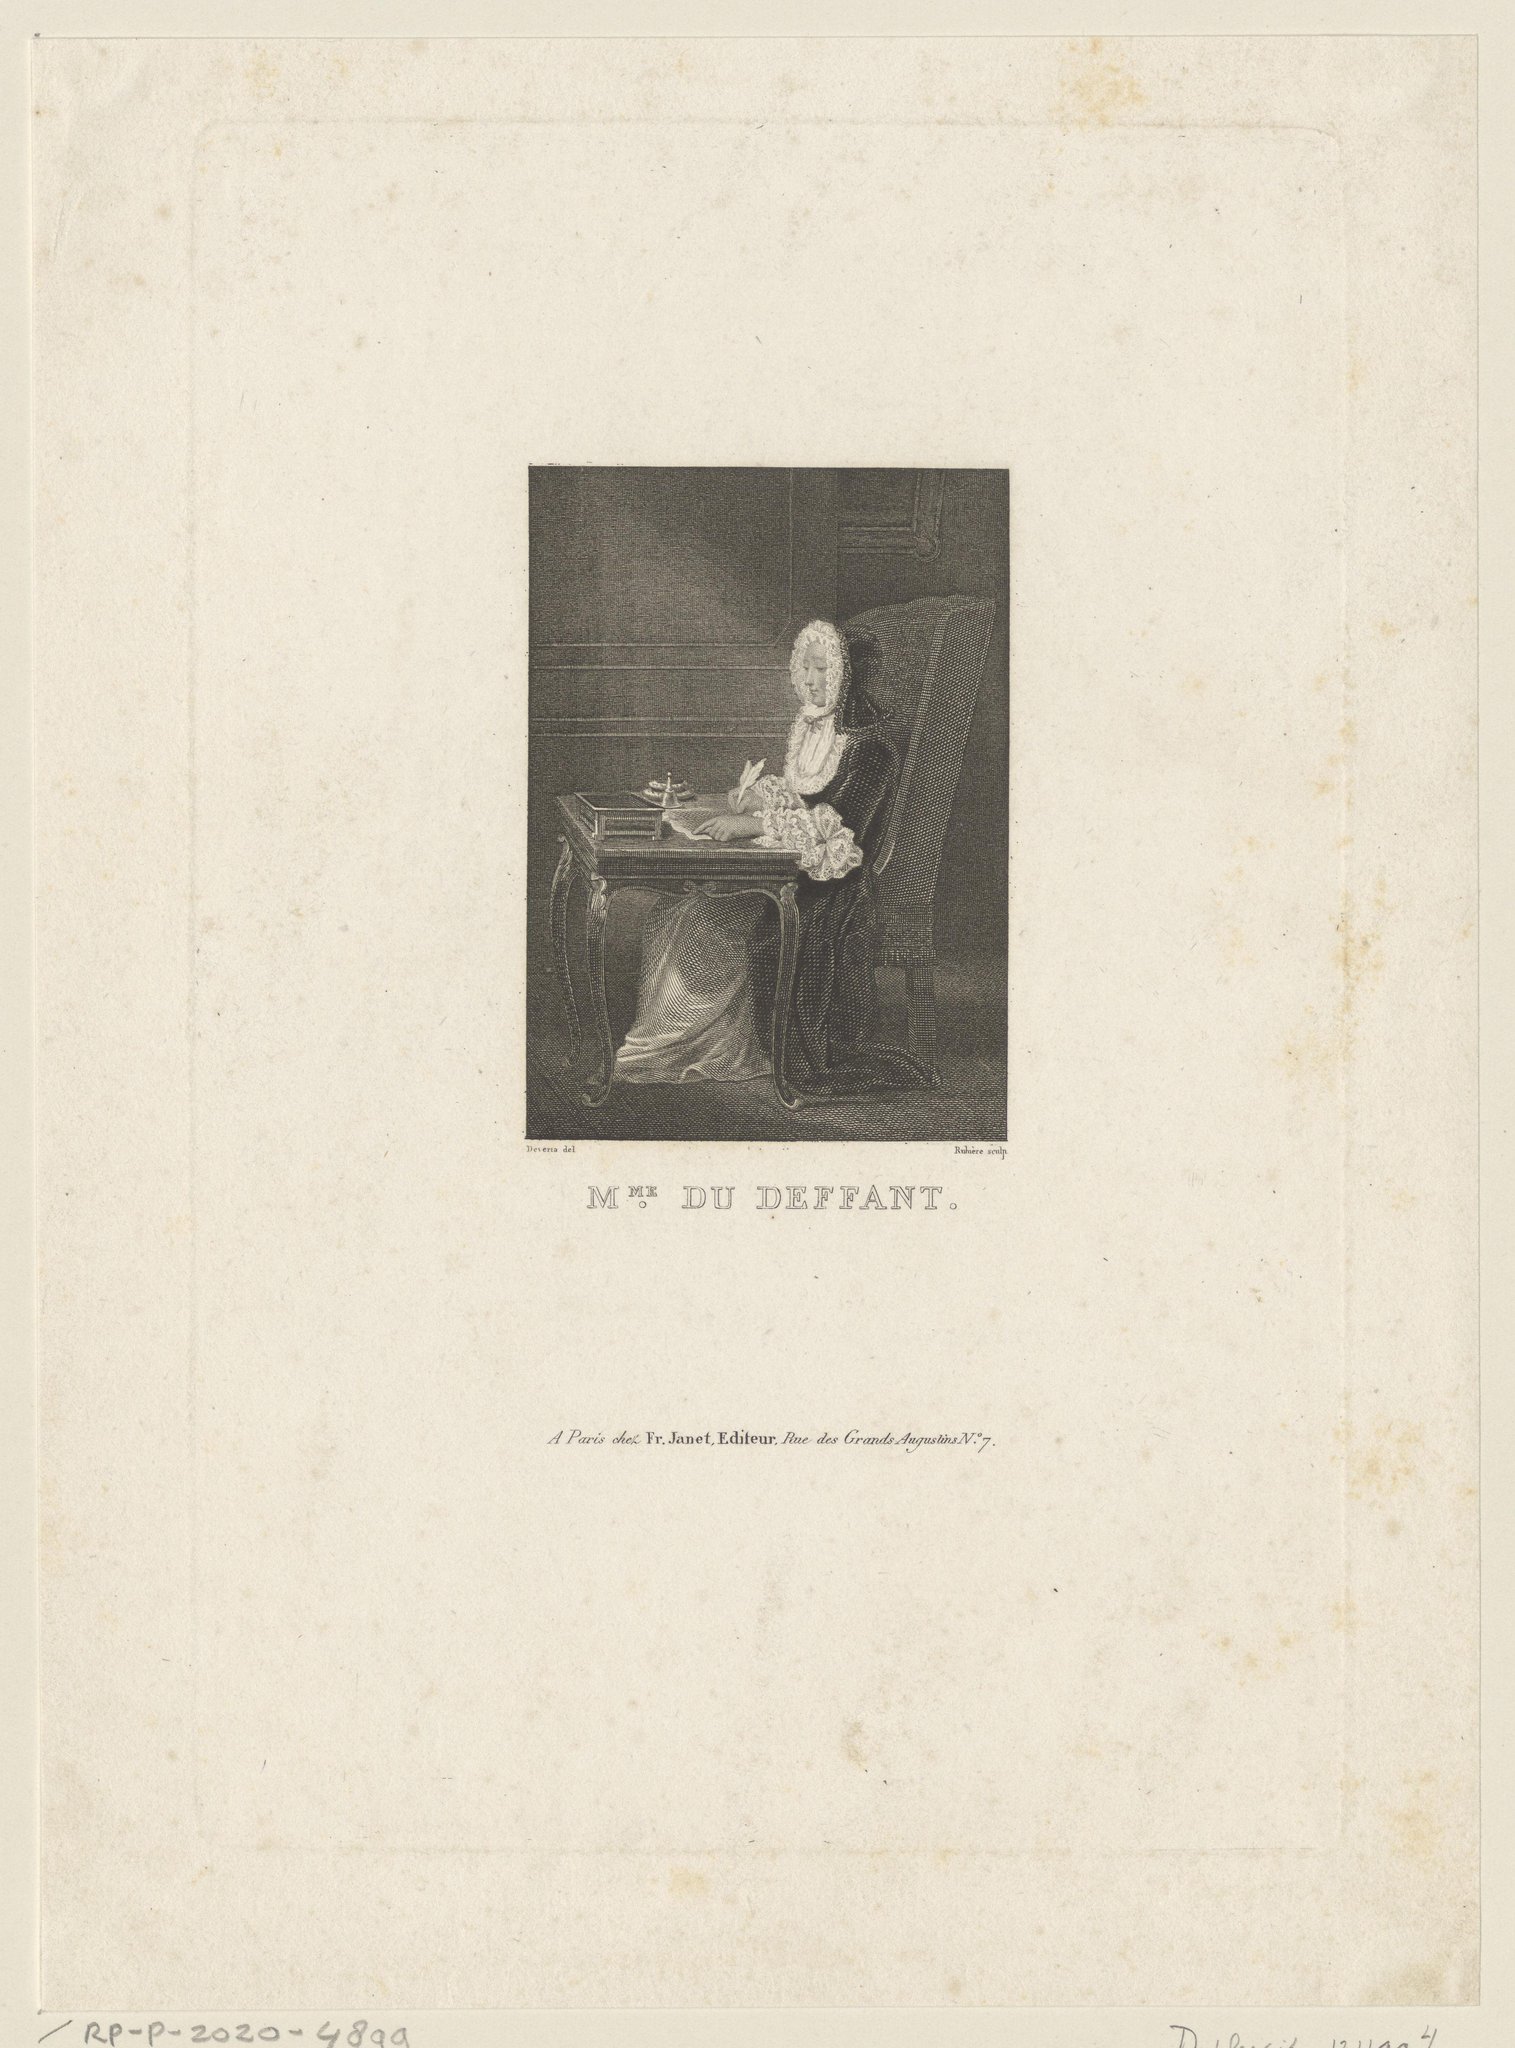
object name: print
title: Portret van Madame du Deffand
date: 1814-1843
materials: paper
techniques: engraving, etching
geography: paris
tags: paris, art lover receiving artists, 'salon (littéraire)', historical persons